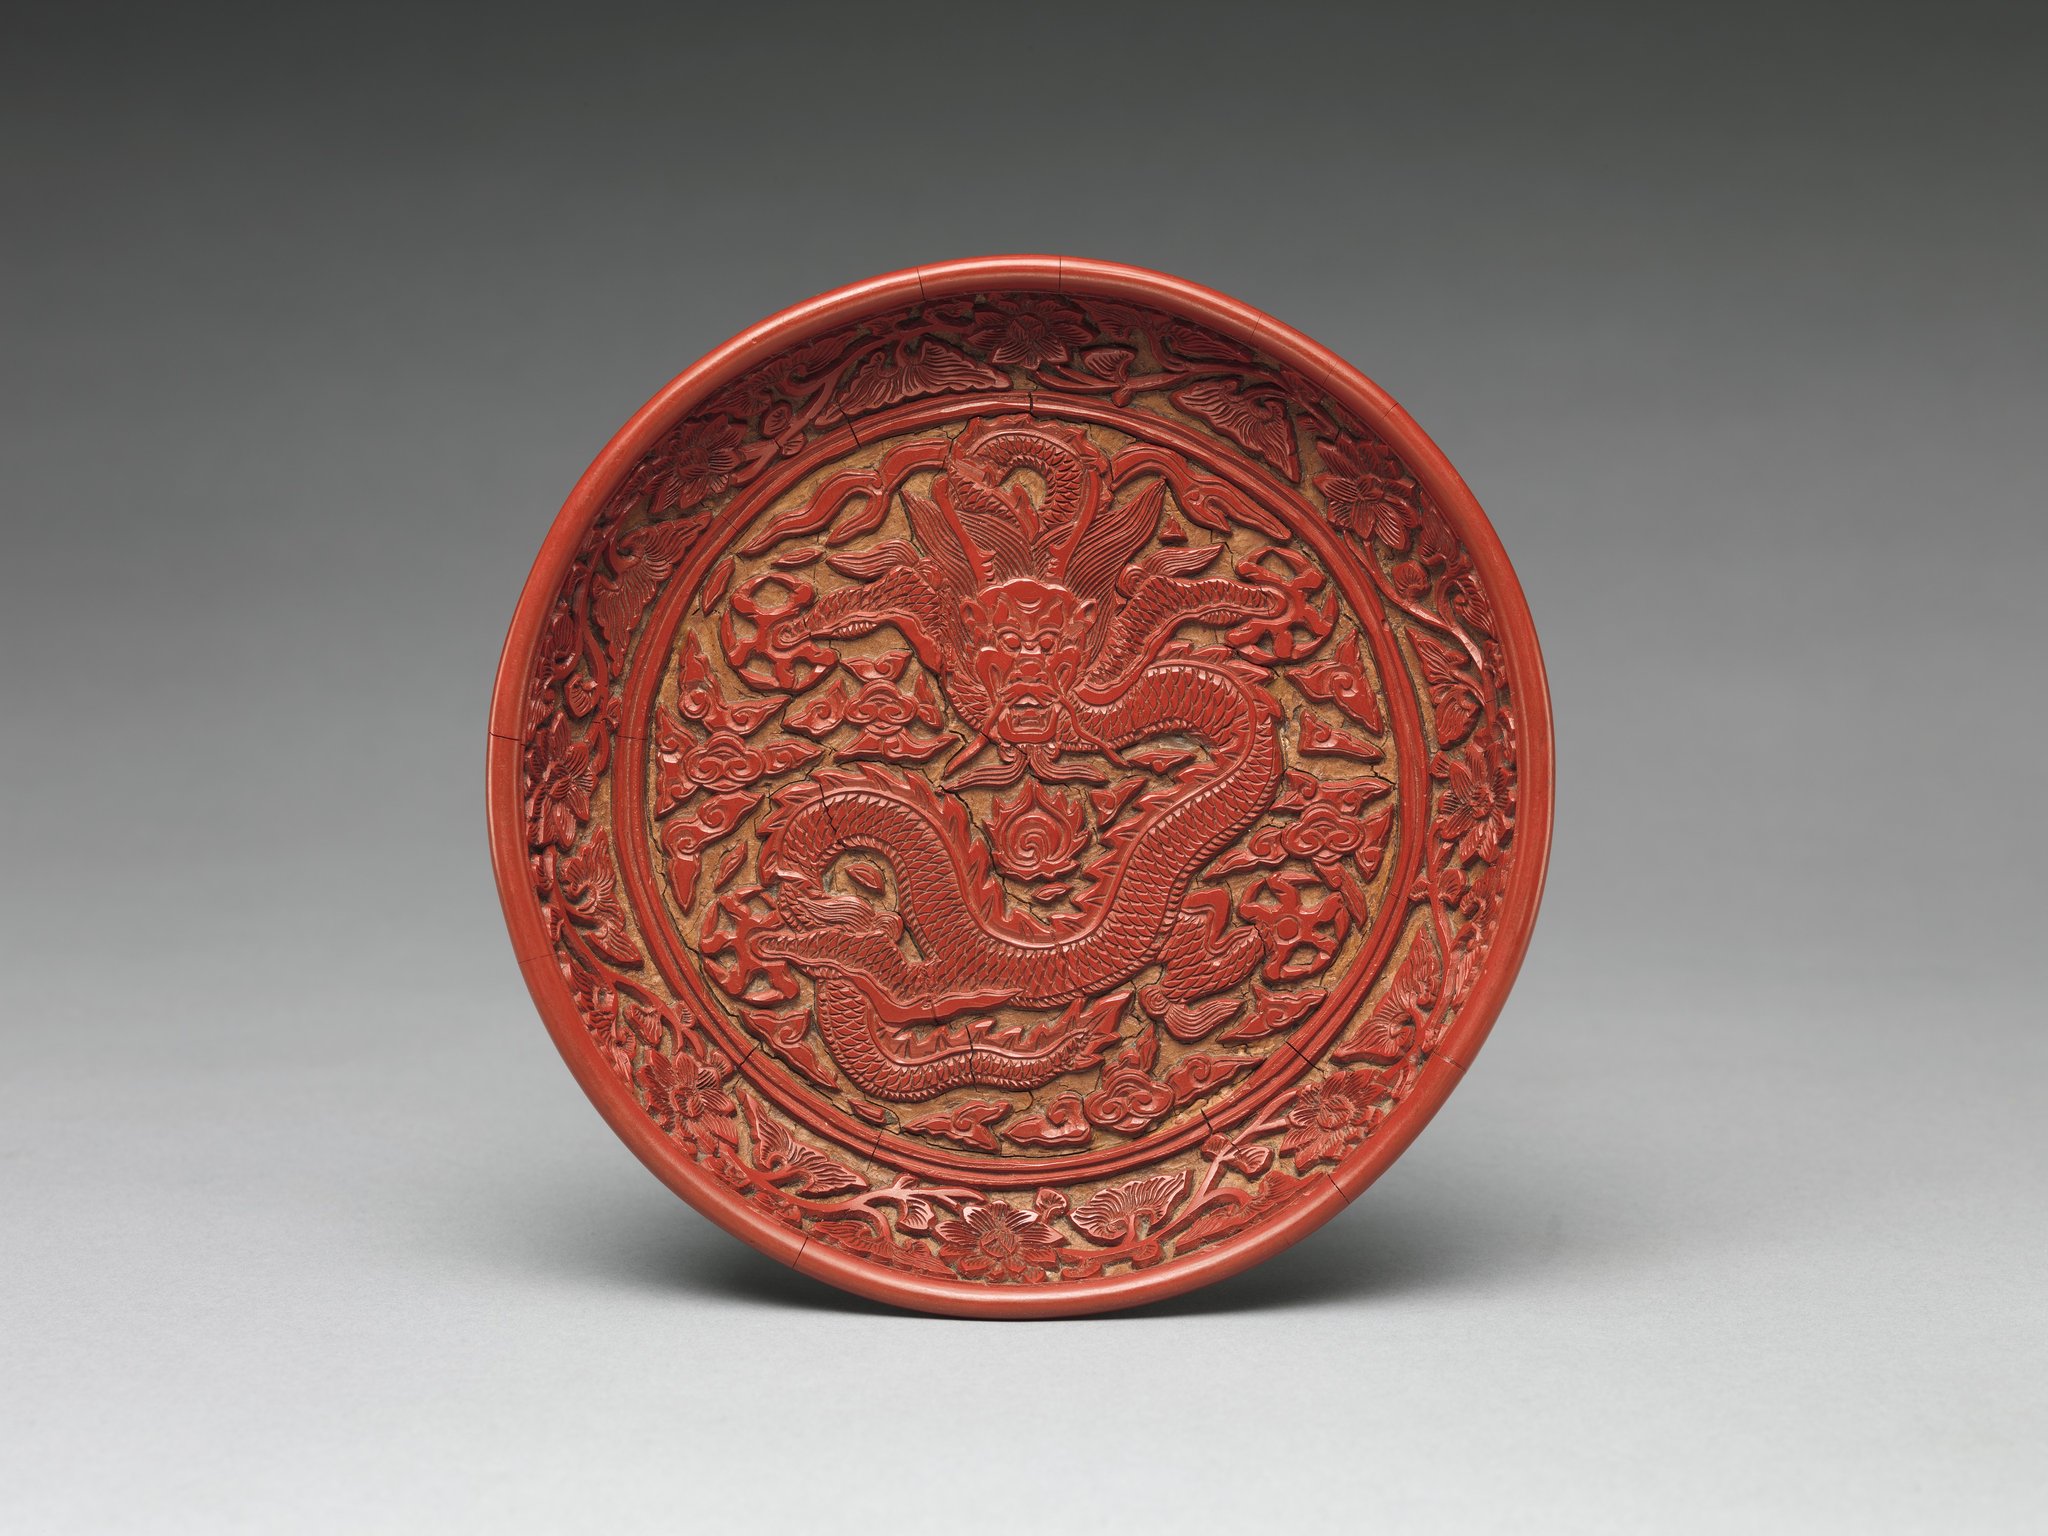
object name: dish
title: Dish with a dragon amid clouds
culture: chinese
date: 1567-1600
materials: lacquer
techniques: carving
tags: dragons